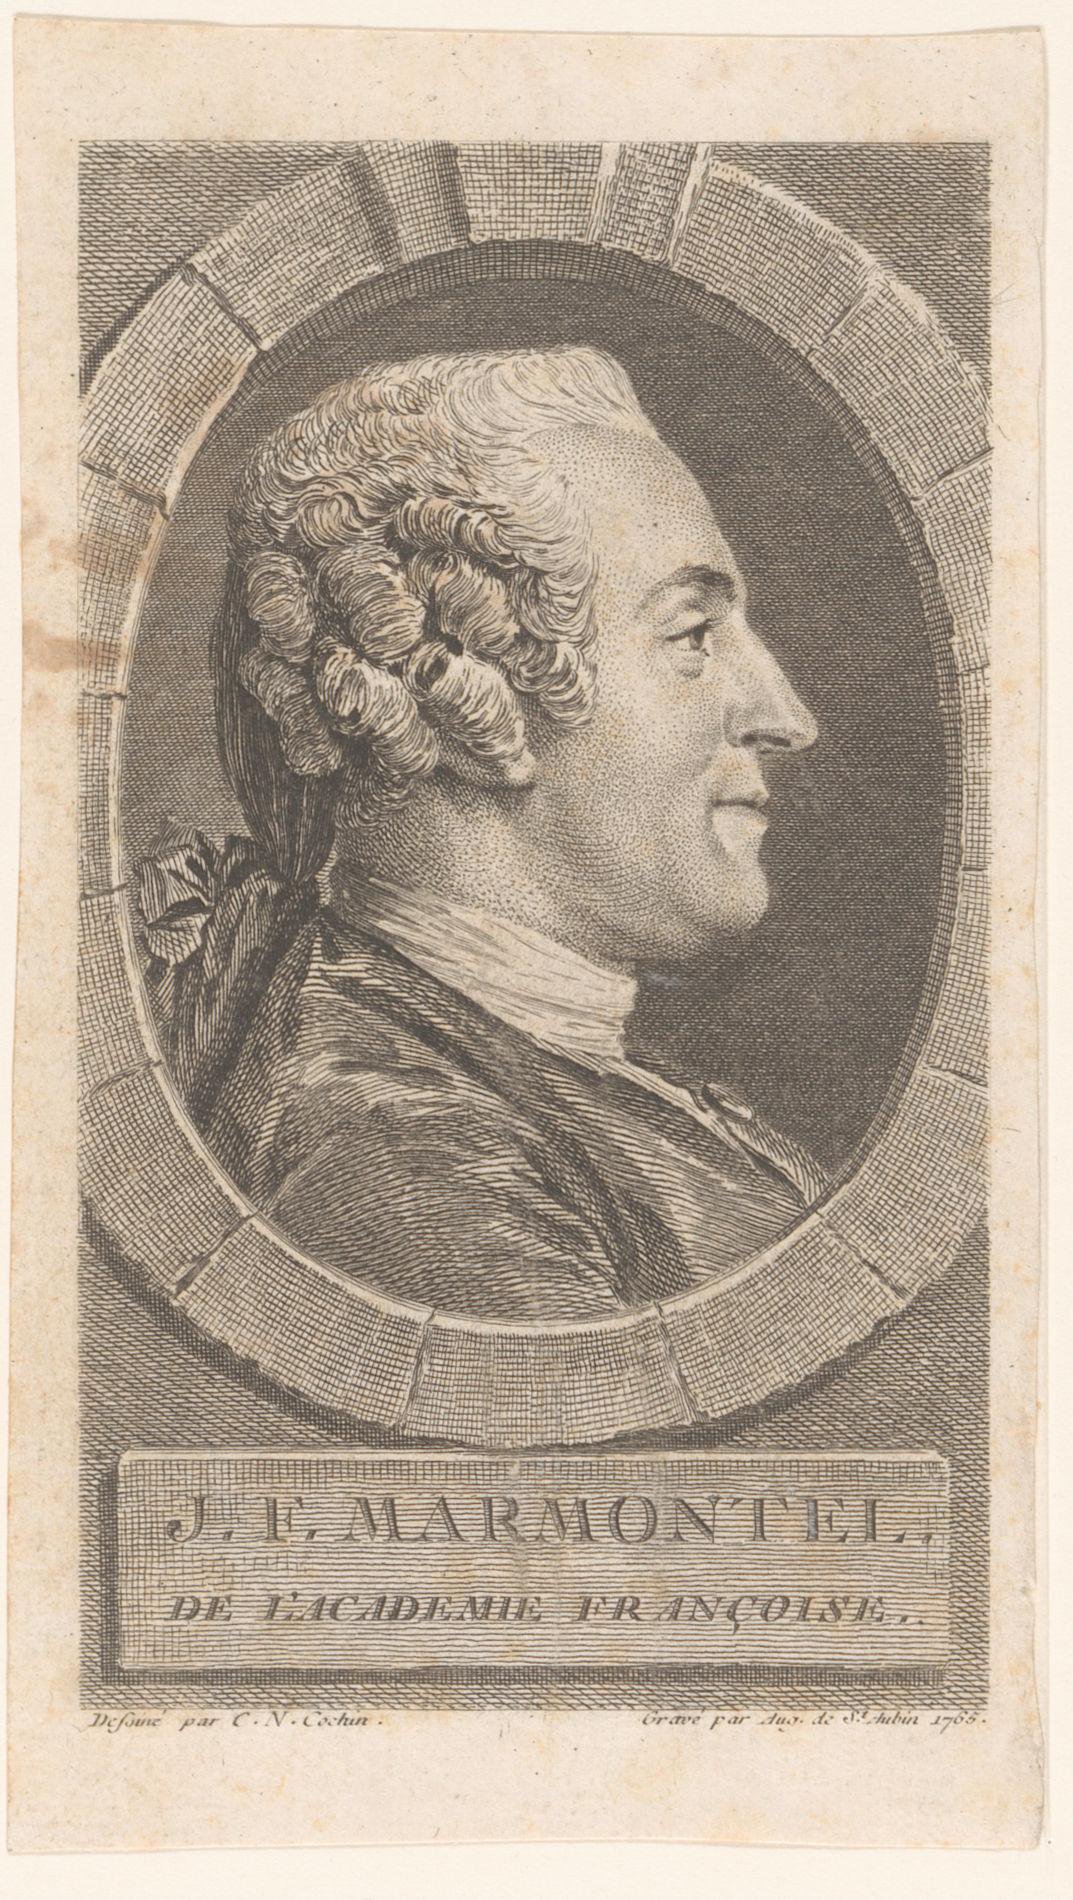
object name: print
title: Portret van Jean François Marmontel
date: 1765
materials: paper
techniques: engraving, etching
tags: jean françois marmontel, historical persons, portrait of a writer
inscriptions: collector's mark: Lugt 2228